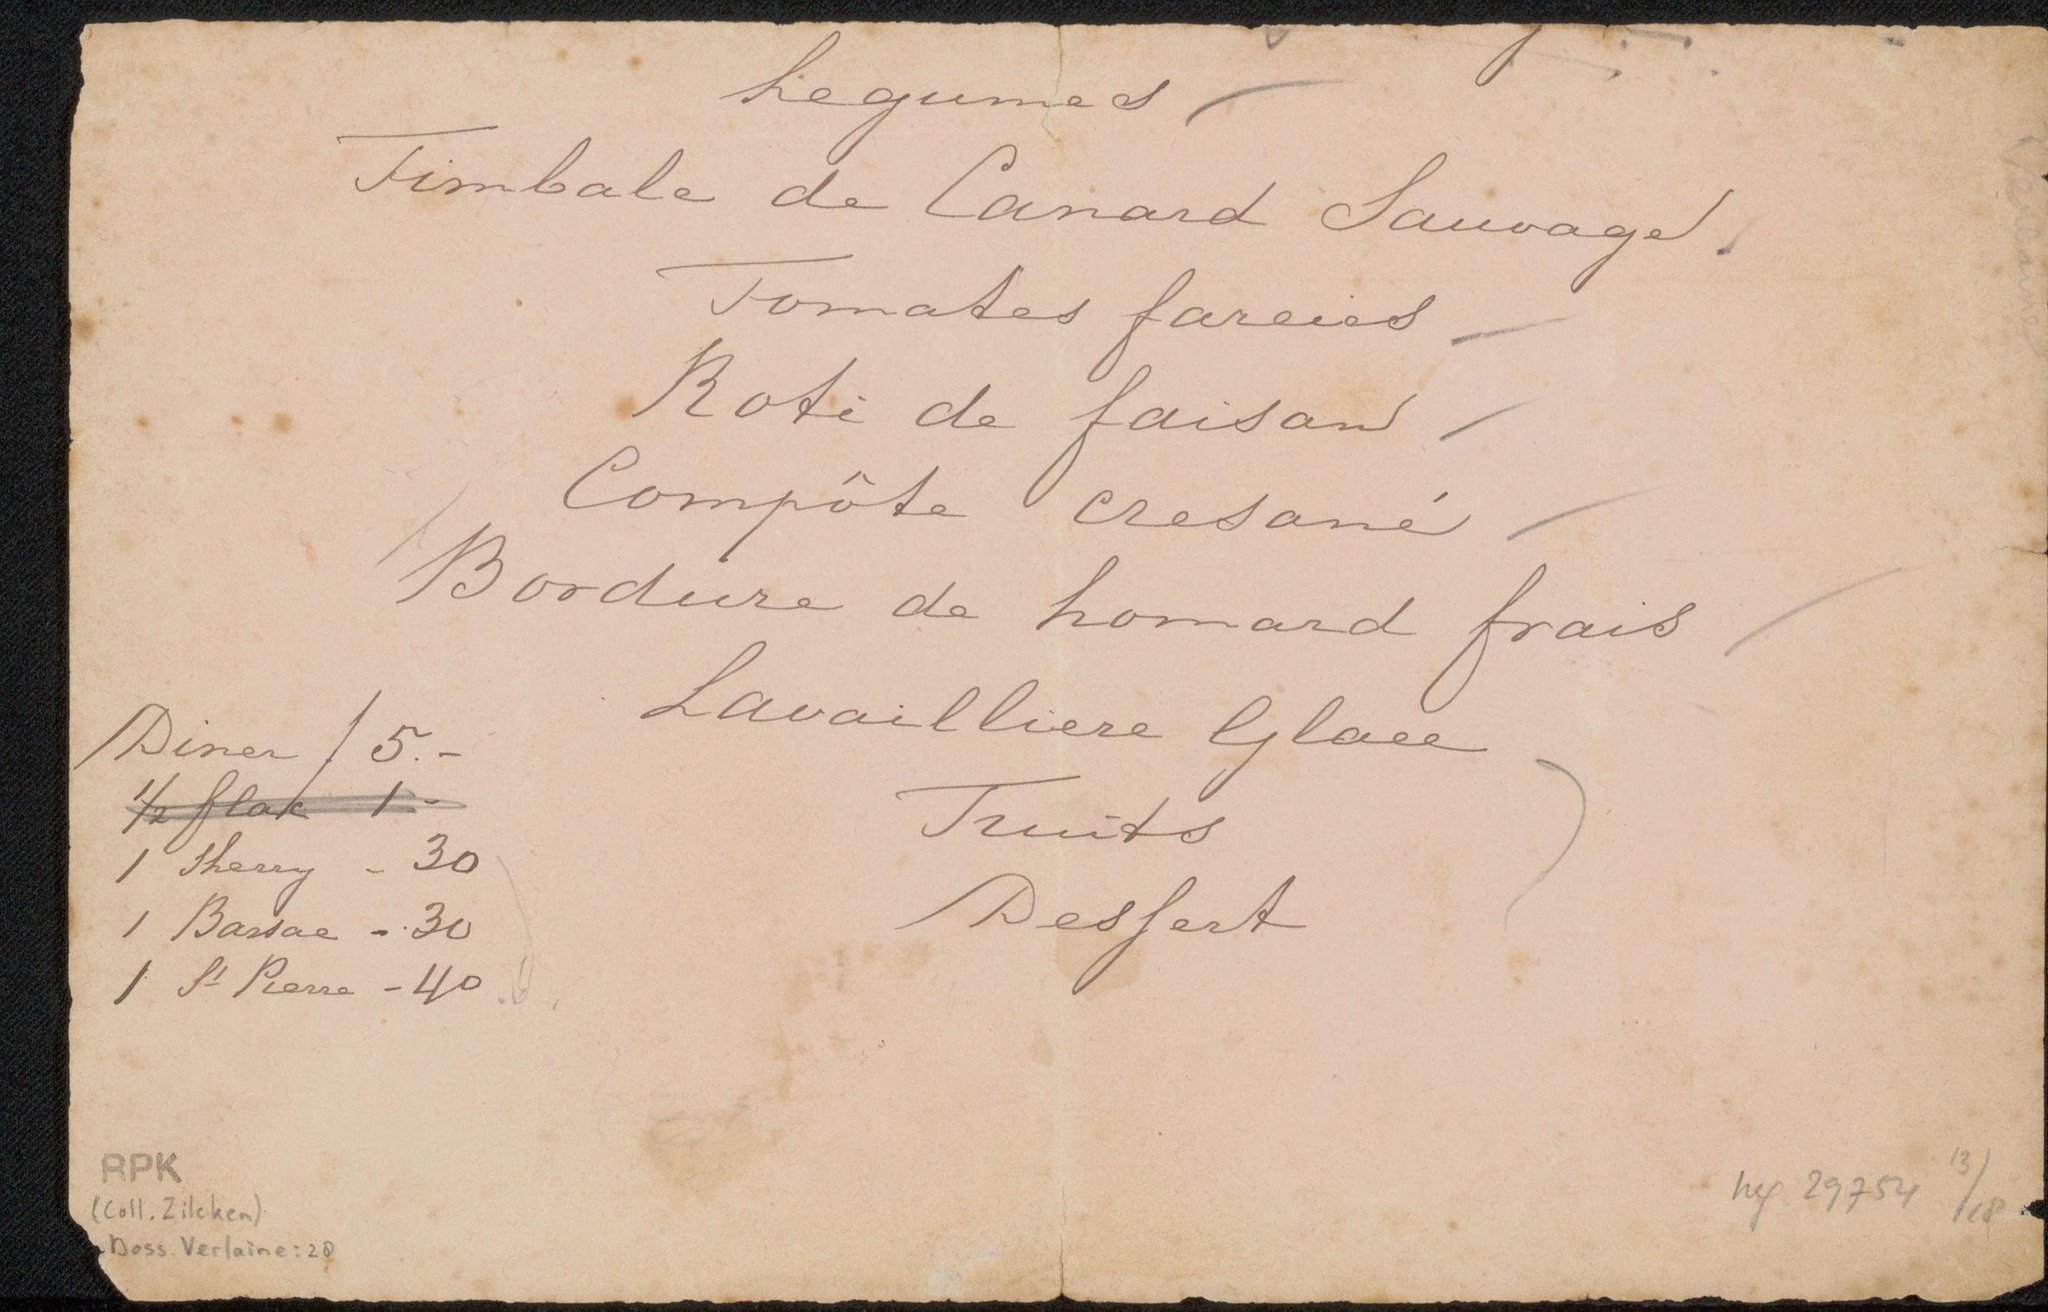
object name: aantekening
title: Tafelschikking voor een diner aangeboden aan Paul Verlaine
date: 1811-1892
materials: ink, paper, pencil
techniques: pen, writing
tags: paris, paul verlaine, draughtsman, philip zilcken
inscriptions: collector's mark: ‘RPK’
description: Tafelschikking bevat verso menu met prijsopgave.